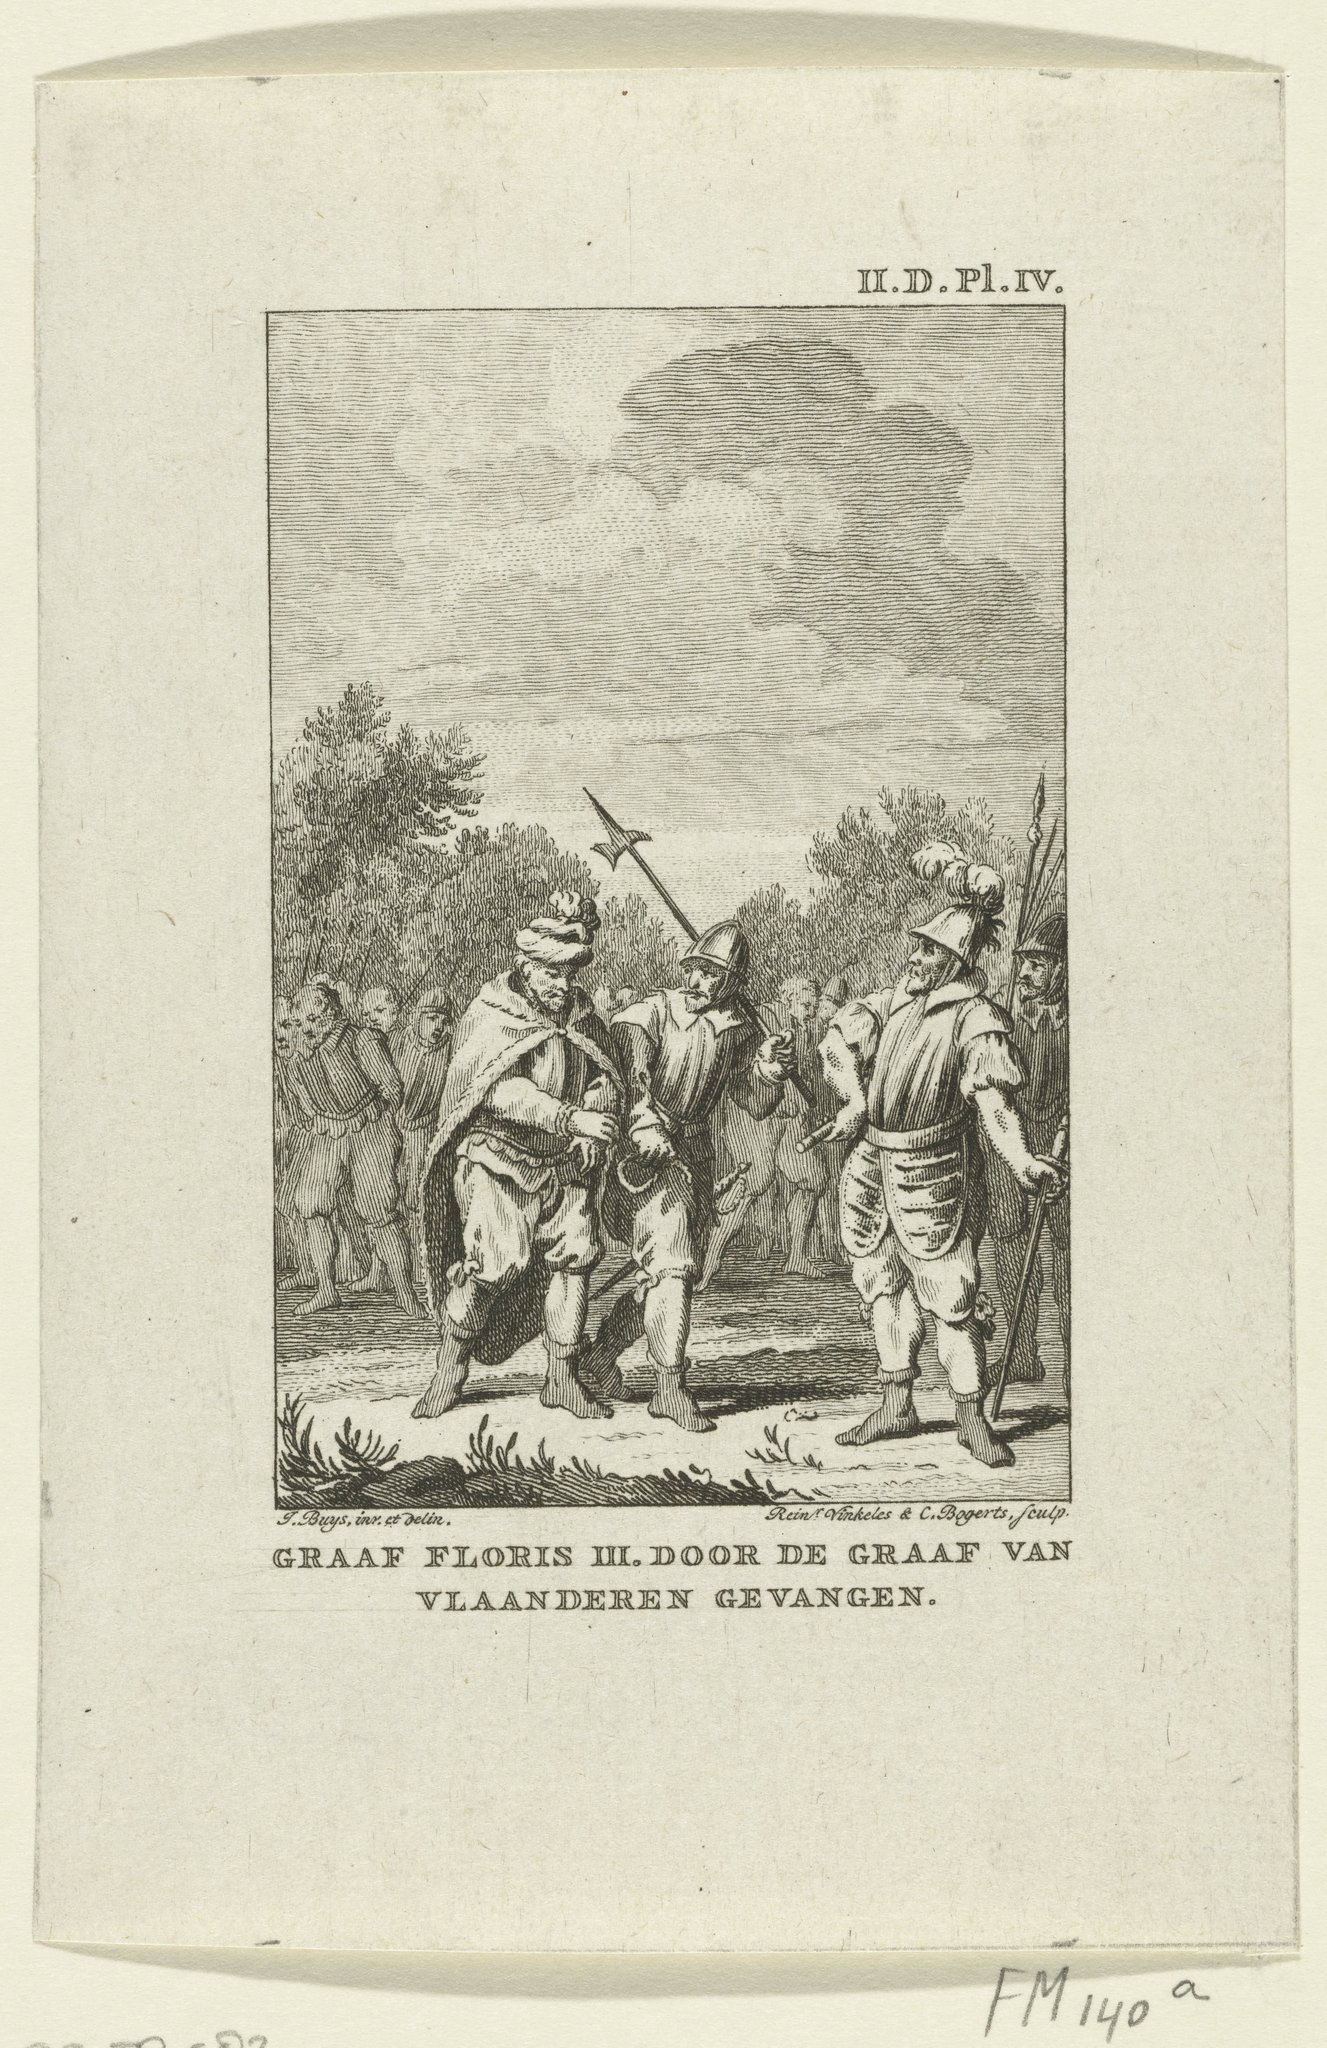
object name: print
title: Graaf Floris III door de graaf van Vlaanderen gevangen, 1165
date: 1780-1795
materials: paper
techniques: etching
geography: netherlands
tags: prisoner of war (after the battle)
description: Illustratie voor: J. Fokke, Geschiedenissen der Vereenigde Nederlanden voor de vaderlandsche jeugd, Johannes Allart, Amsterdam 1783-1795, 25 delen, dl. II, pl. IV. Staat met de letter.